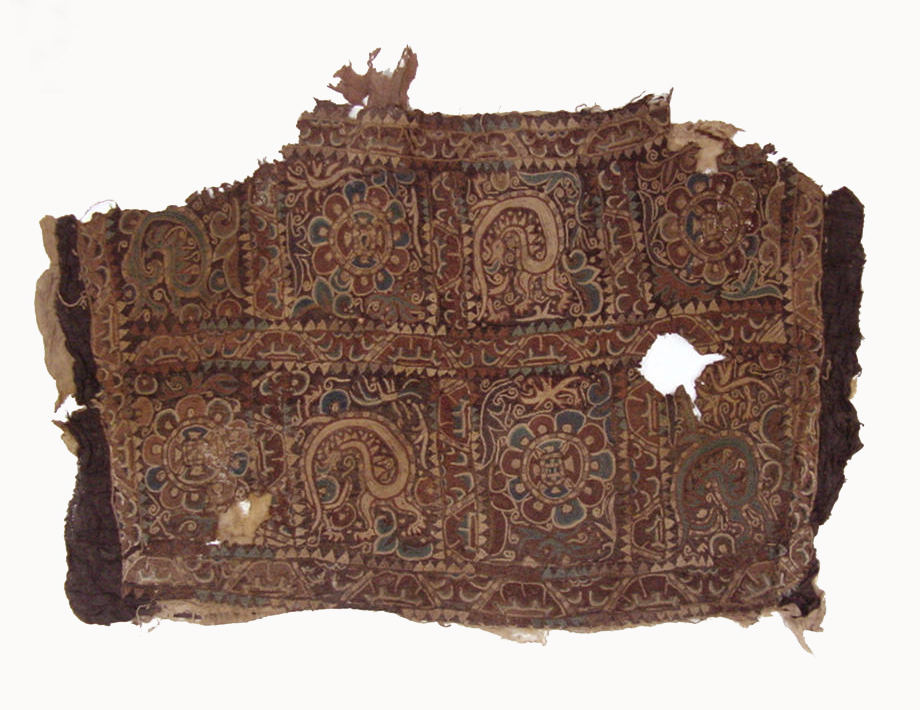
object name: textile fragment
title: Embroidered textile with dragons and lotuses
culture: chinese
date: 601-800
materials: silk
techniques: embroidery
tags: dragons,lotuses